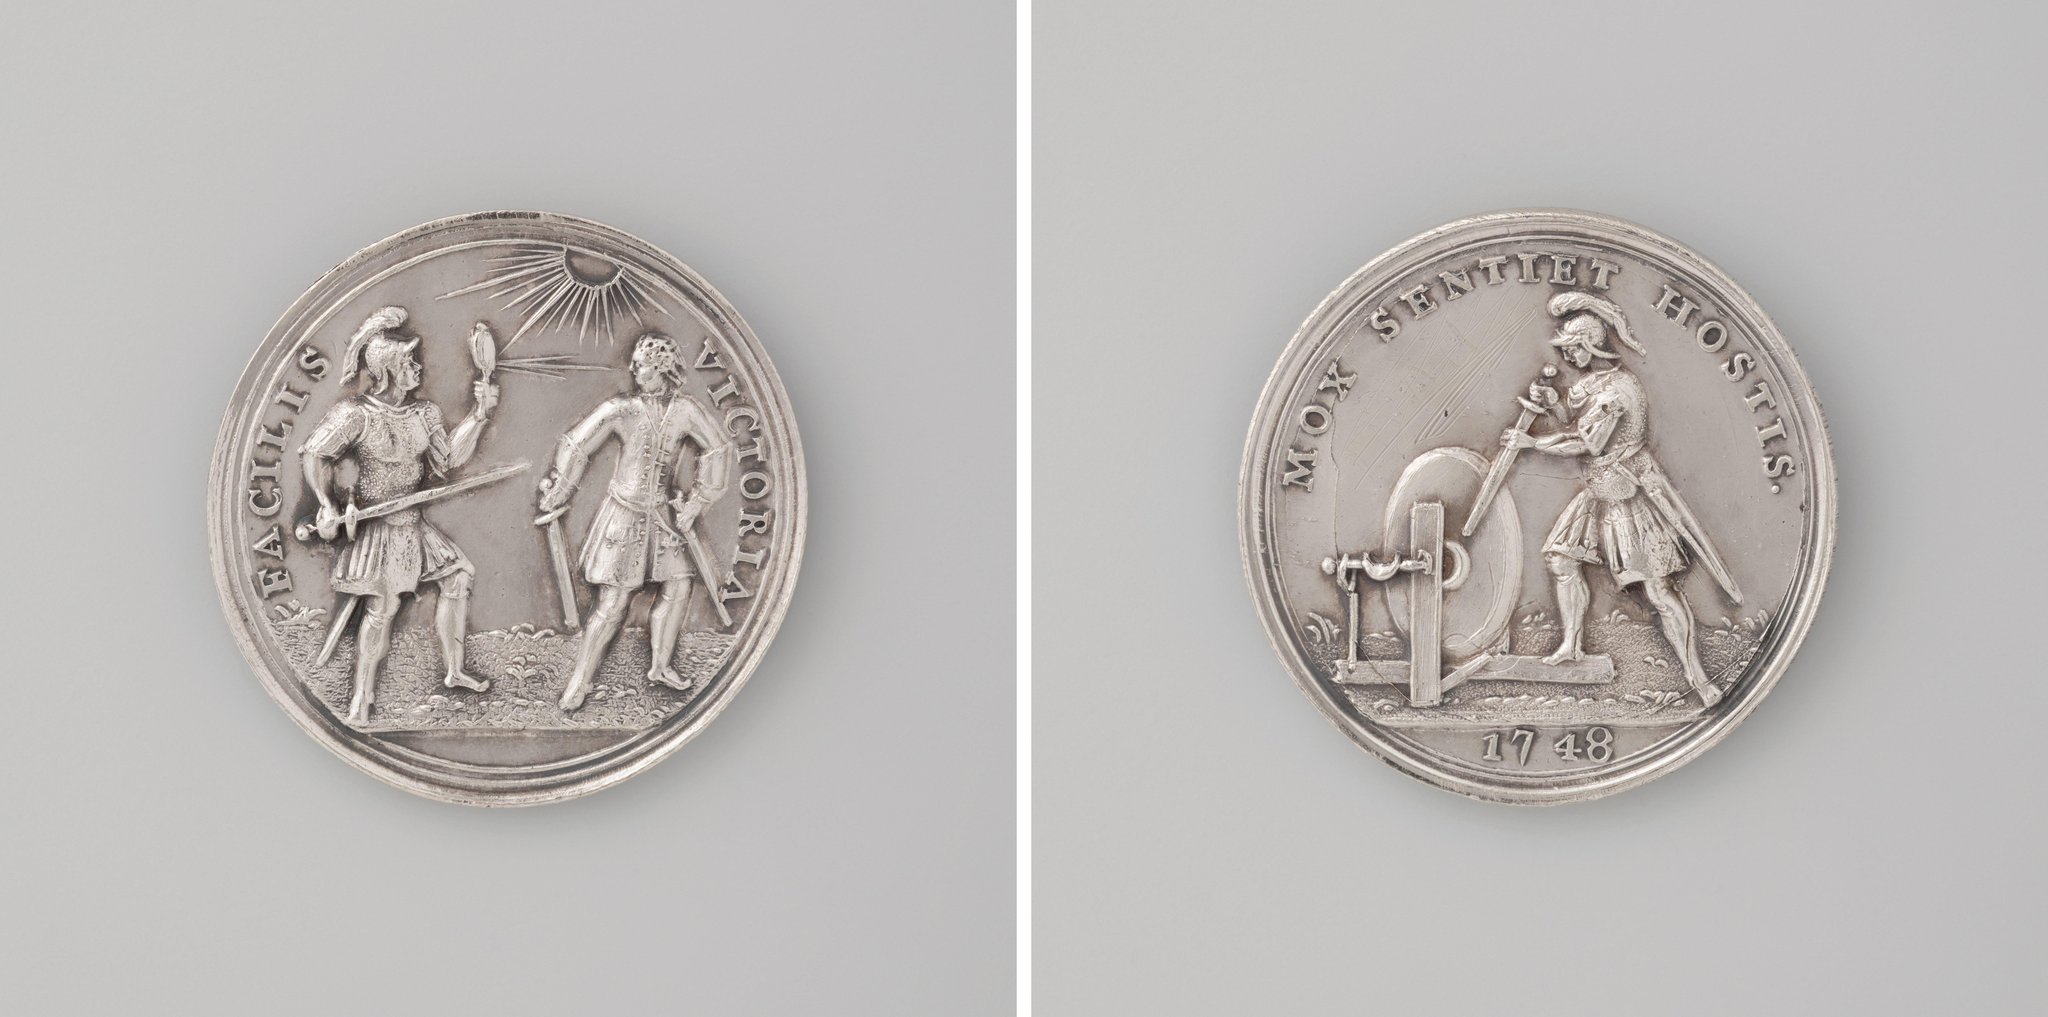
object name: medal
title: Gelegenheidspenning vrede te Aken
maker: Anonymous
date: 1748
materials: silver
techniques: striking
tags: aken, vrede van aken (1748)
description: Zilveren penning. Voorzijde: twee soldaten in gevecht, waarvan linker zijn tegenstander verblindt met behulp van spiegel binnen omschrift. Keerzijde: soldaat slijpt zijn zwaard aan slijpsteen binnen omschrift; afsnede: jaartal